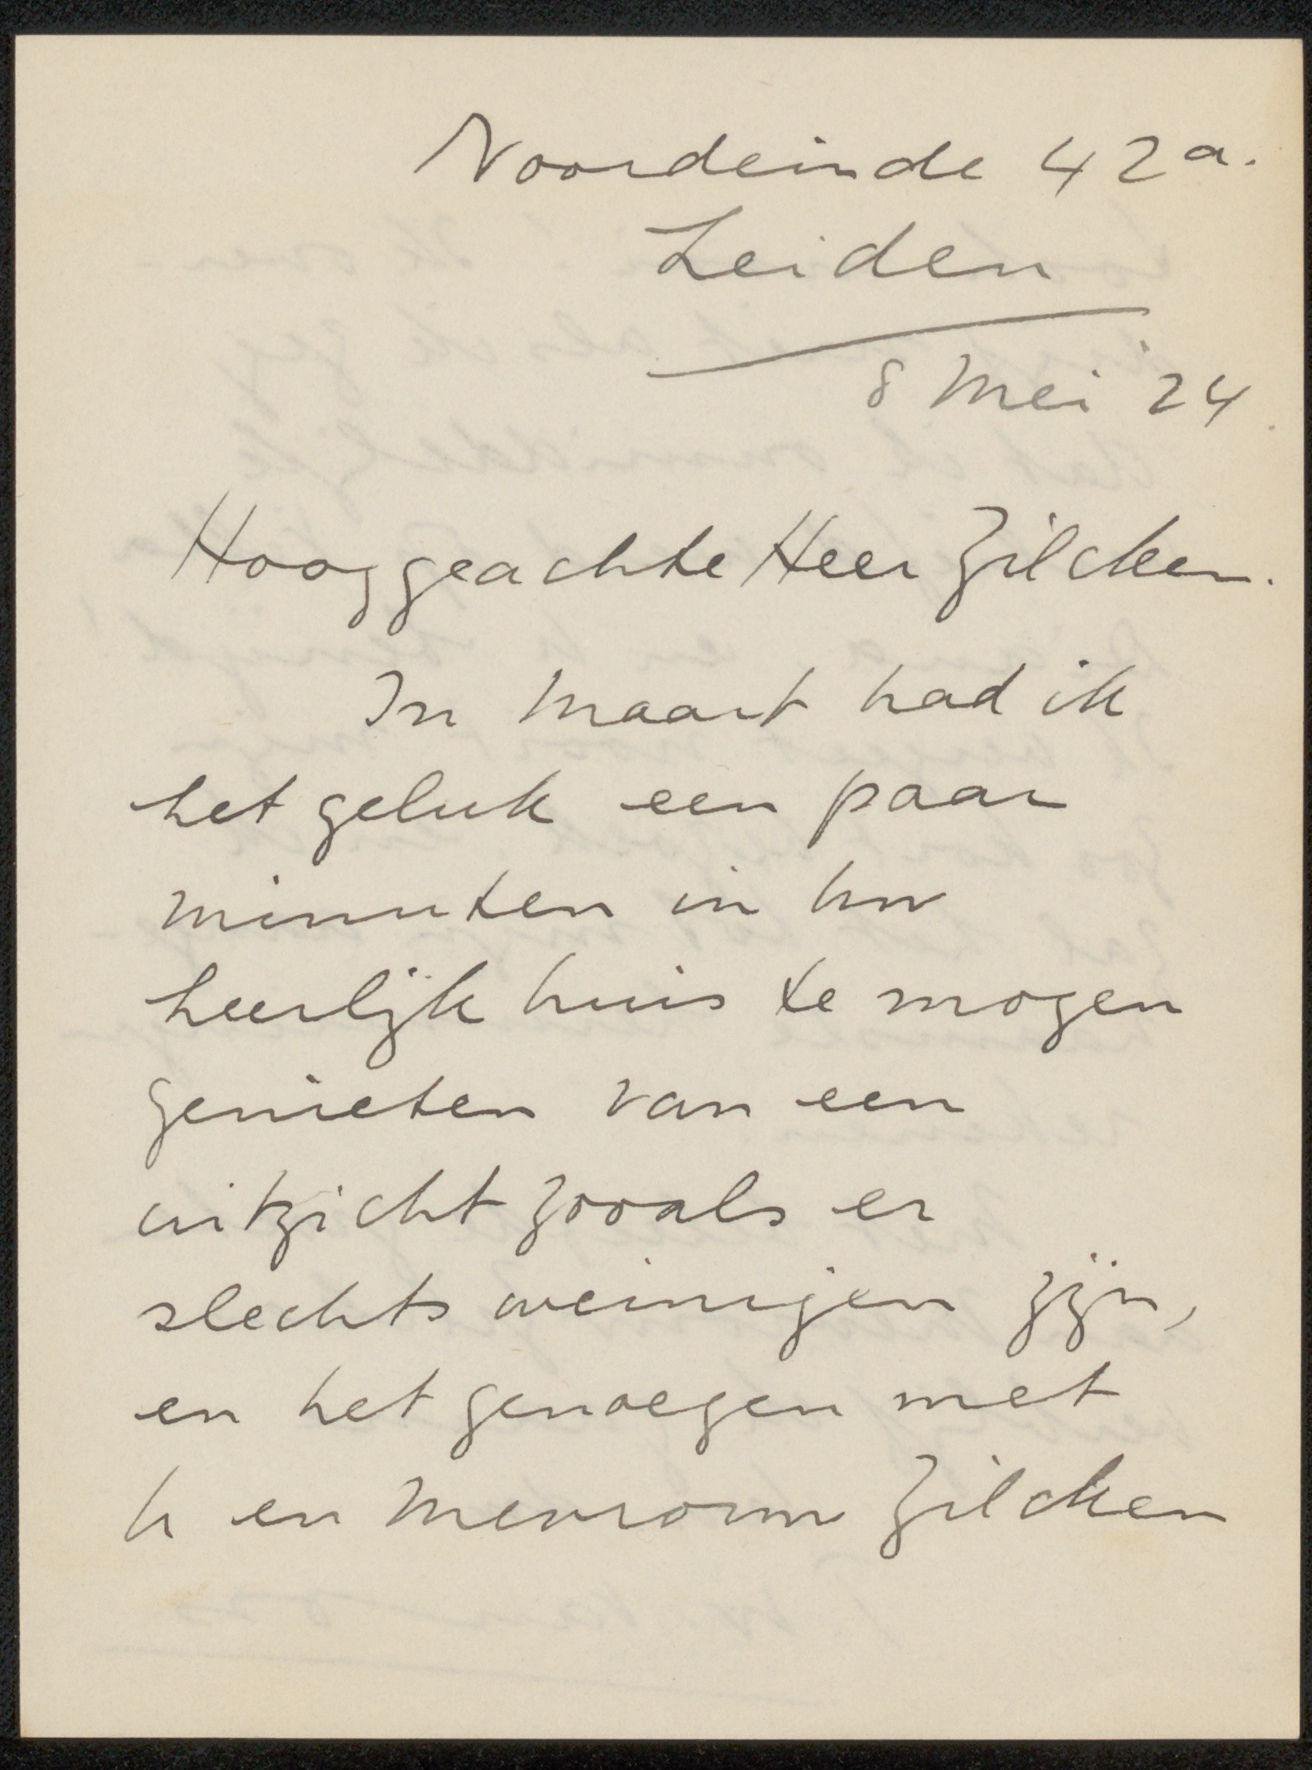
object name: letter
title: Brief aan Philip Zilcken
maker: tom w. van oss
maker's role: painter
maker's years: 1901-1941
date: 1924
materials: ink, paper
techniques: pen, writing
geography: leiden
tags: draughtsman, philip zilcken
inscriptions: collector's mark: ‘RPK’